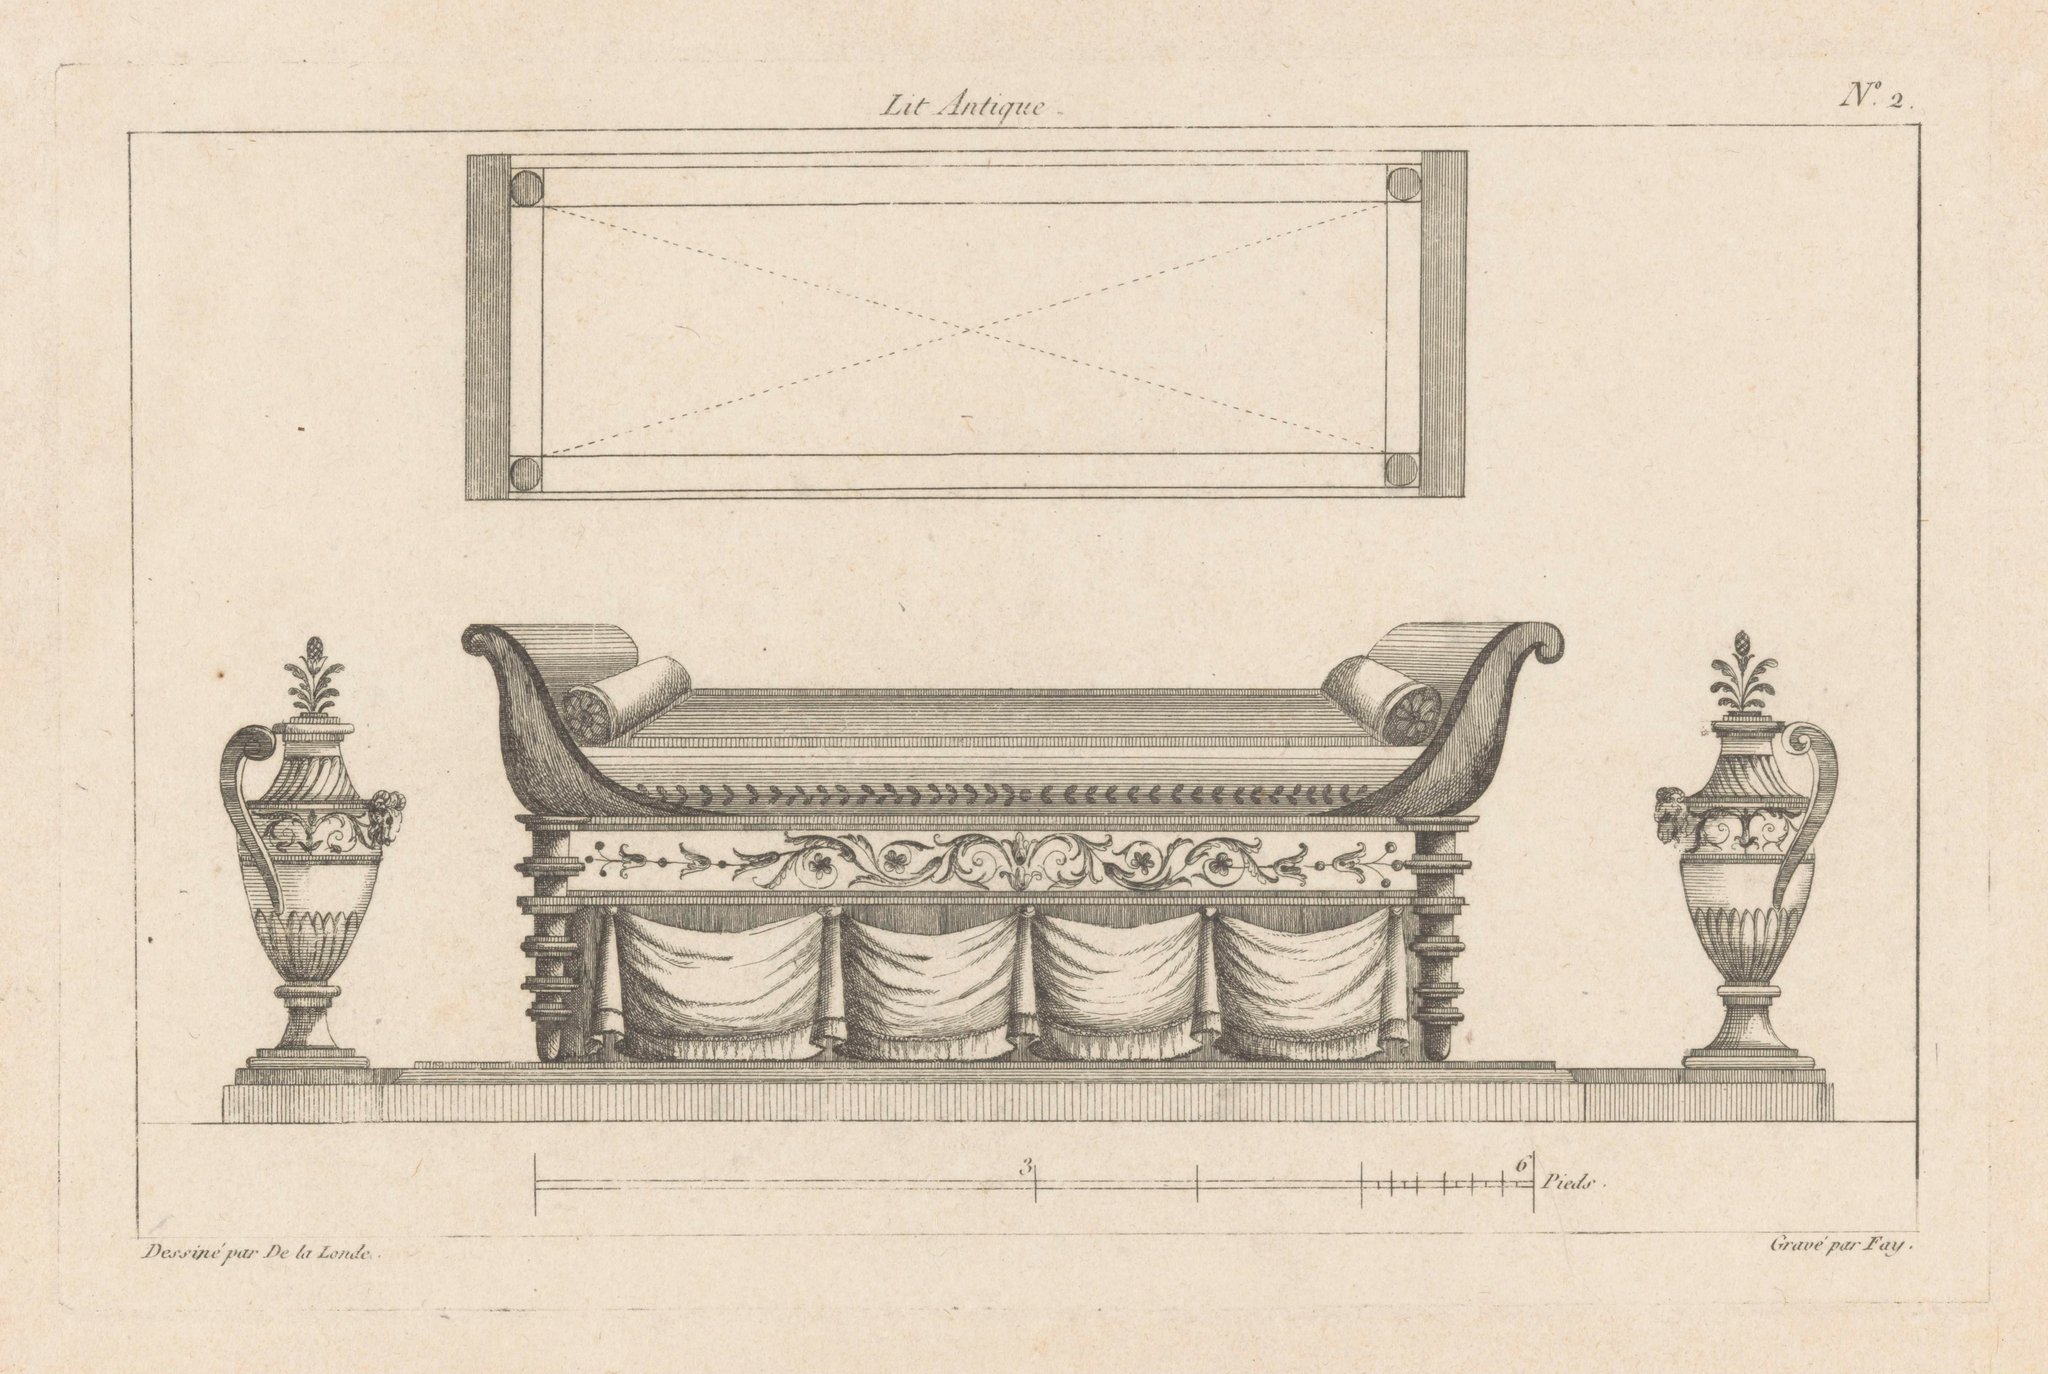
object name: print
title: IVe Cahier de Meubles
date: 1784-1796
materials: paper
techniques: etching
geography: paris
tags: bed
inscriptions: collector's mark: Lugt 2760, collector's mark: Lugt 2228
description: Een geornamenteerde aanligbed met twee rolkussens, vlechtwerk en draperieën. Twee vazen met oor flankeren het bed.